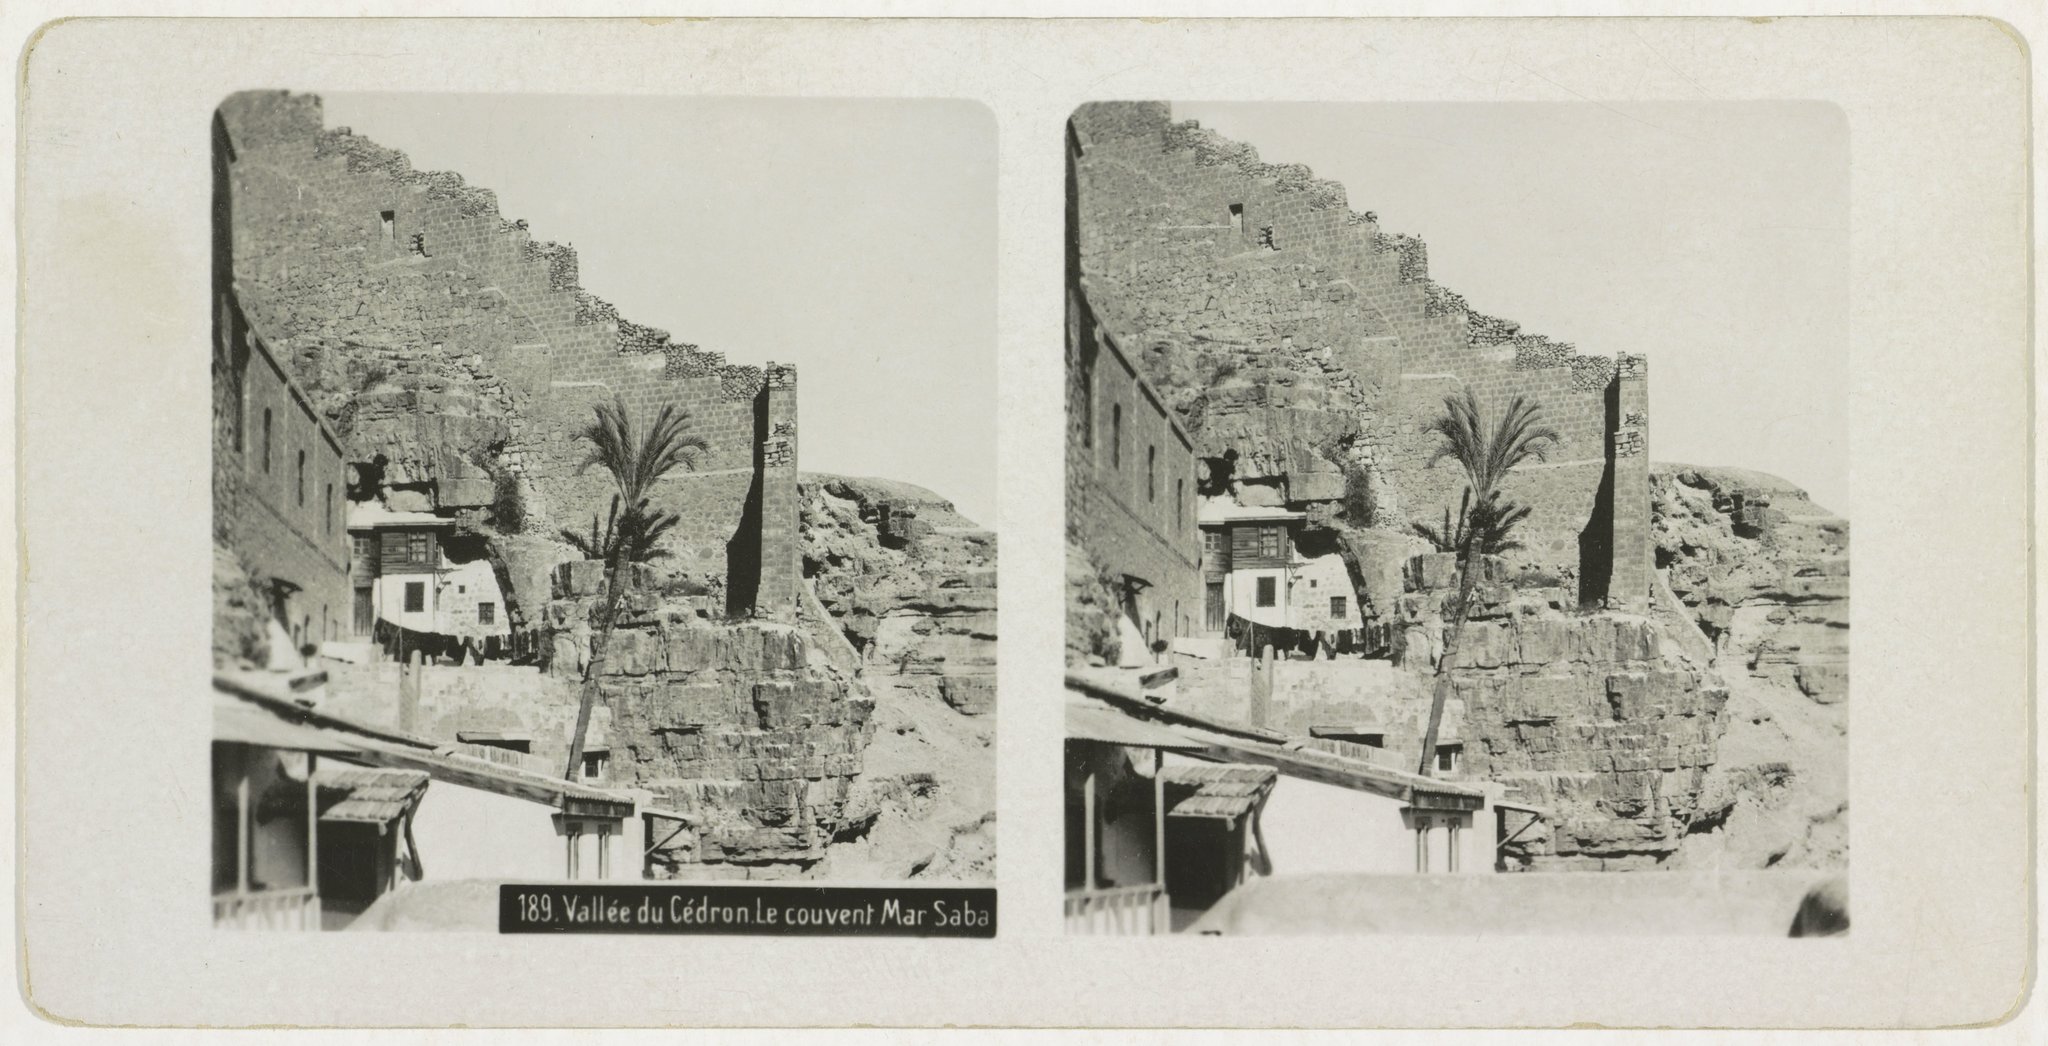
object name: stereograph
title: Vallée du Cédron. Le couvent Mar Saba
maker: richard sochor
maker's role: painter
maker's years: 1867-1925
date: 1903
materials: paper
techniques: gelatin silver print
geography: mar saba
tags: abbey, monastery, convent ~ roman catholic church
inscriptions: address: ‘Parklaan 49/ HAARLEM/ (Holland)’, inscription: ‘Deze stereo-foto's worden in den handel gebracht en en gros en/ en détail verkocht door de ......... (...)’, number: ‘189.’, monogram, inscription: ‘Déposée.’